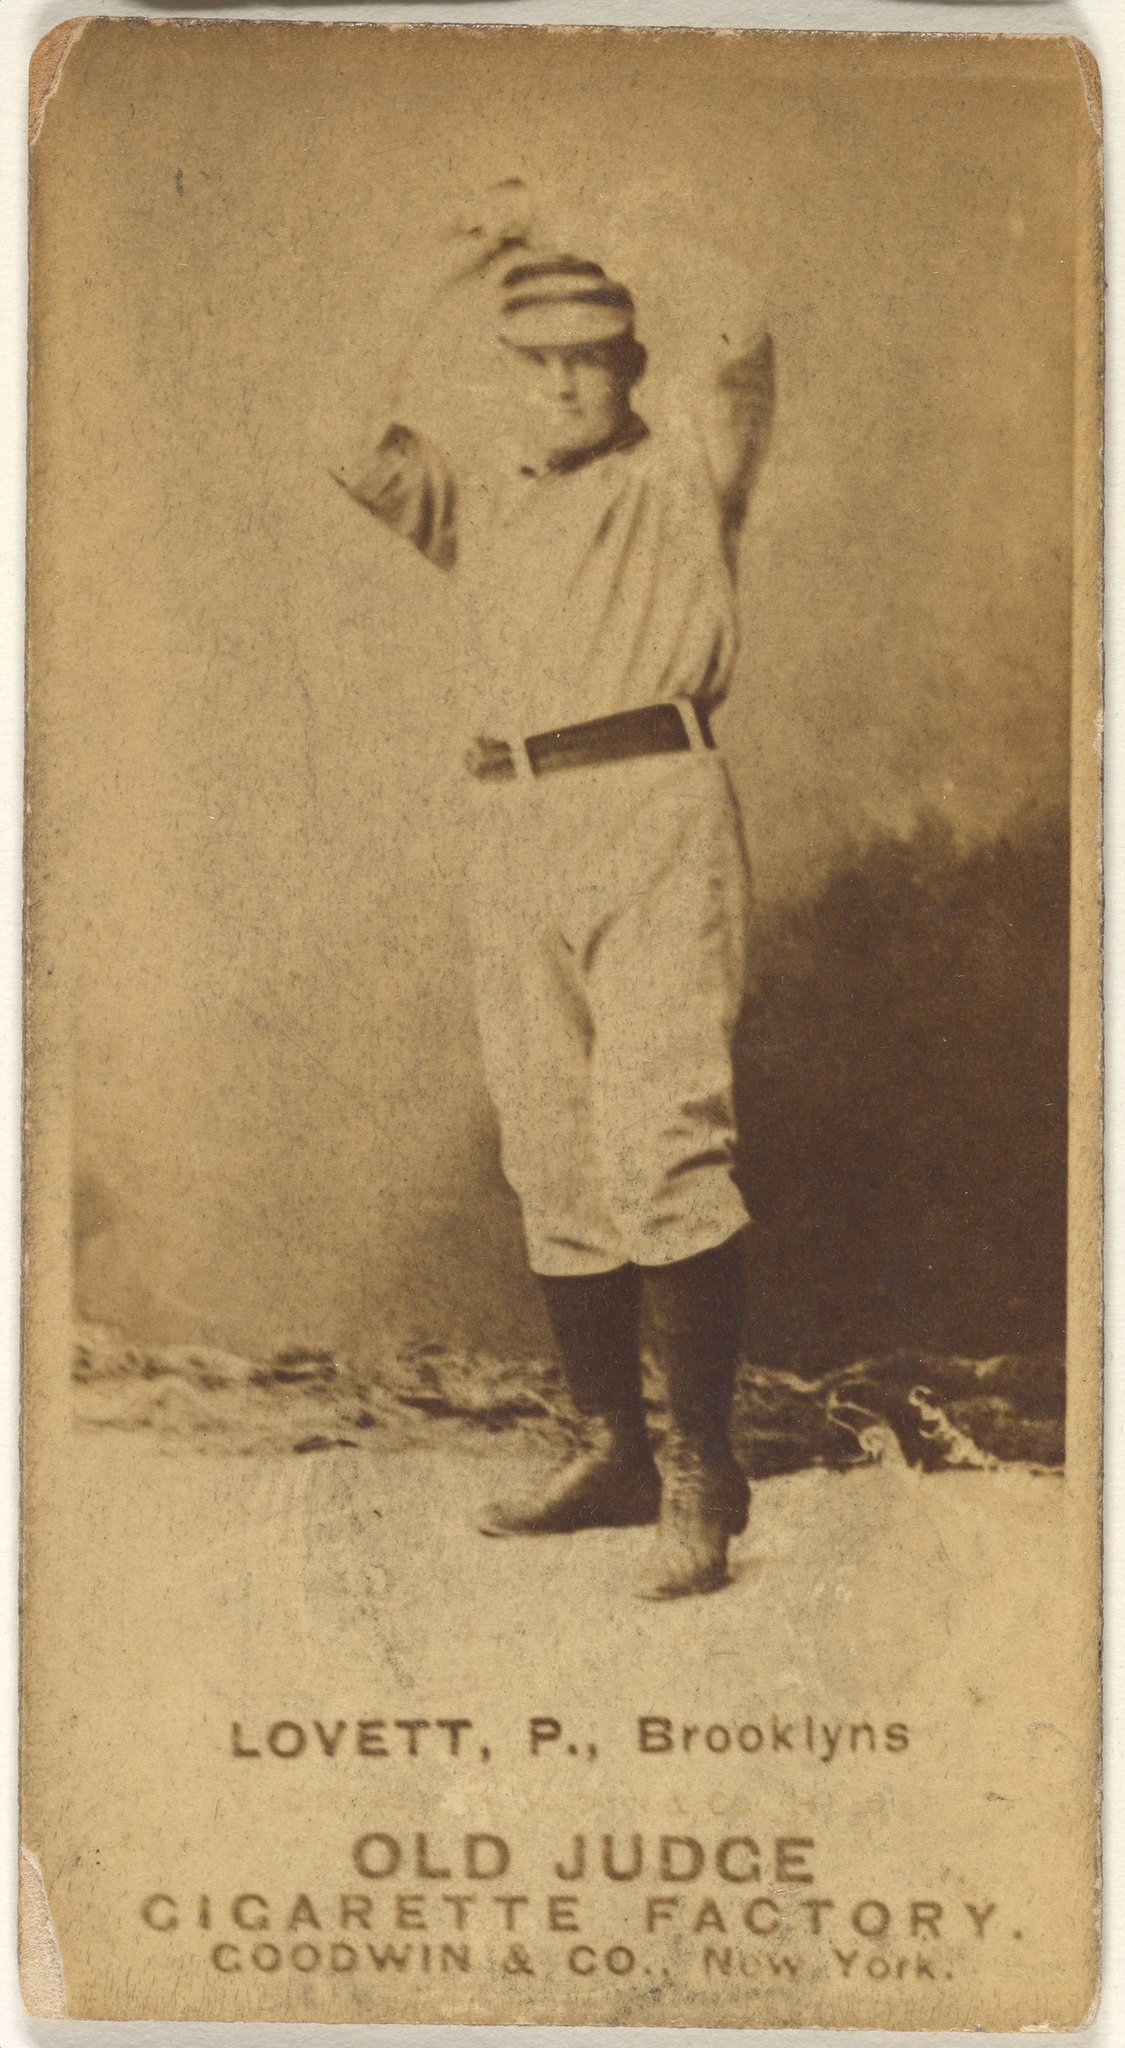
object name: baseball card, photograph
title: Lovett, Pitcher, Brooklyn, from the Old Judge series (N172) for Old Judge Cigarettes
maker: goodwin & company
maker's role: publisher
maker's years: 1850-1950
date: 1887-1890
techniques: albumen silver print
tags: men,portraits,baseball,athletes